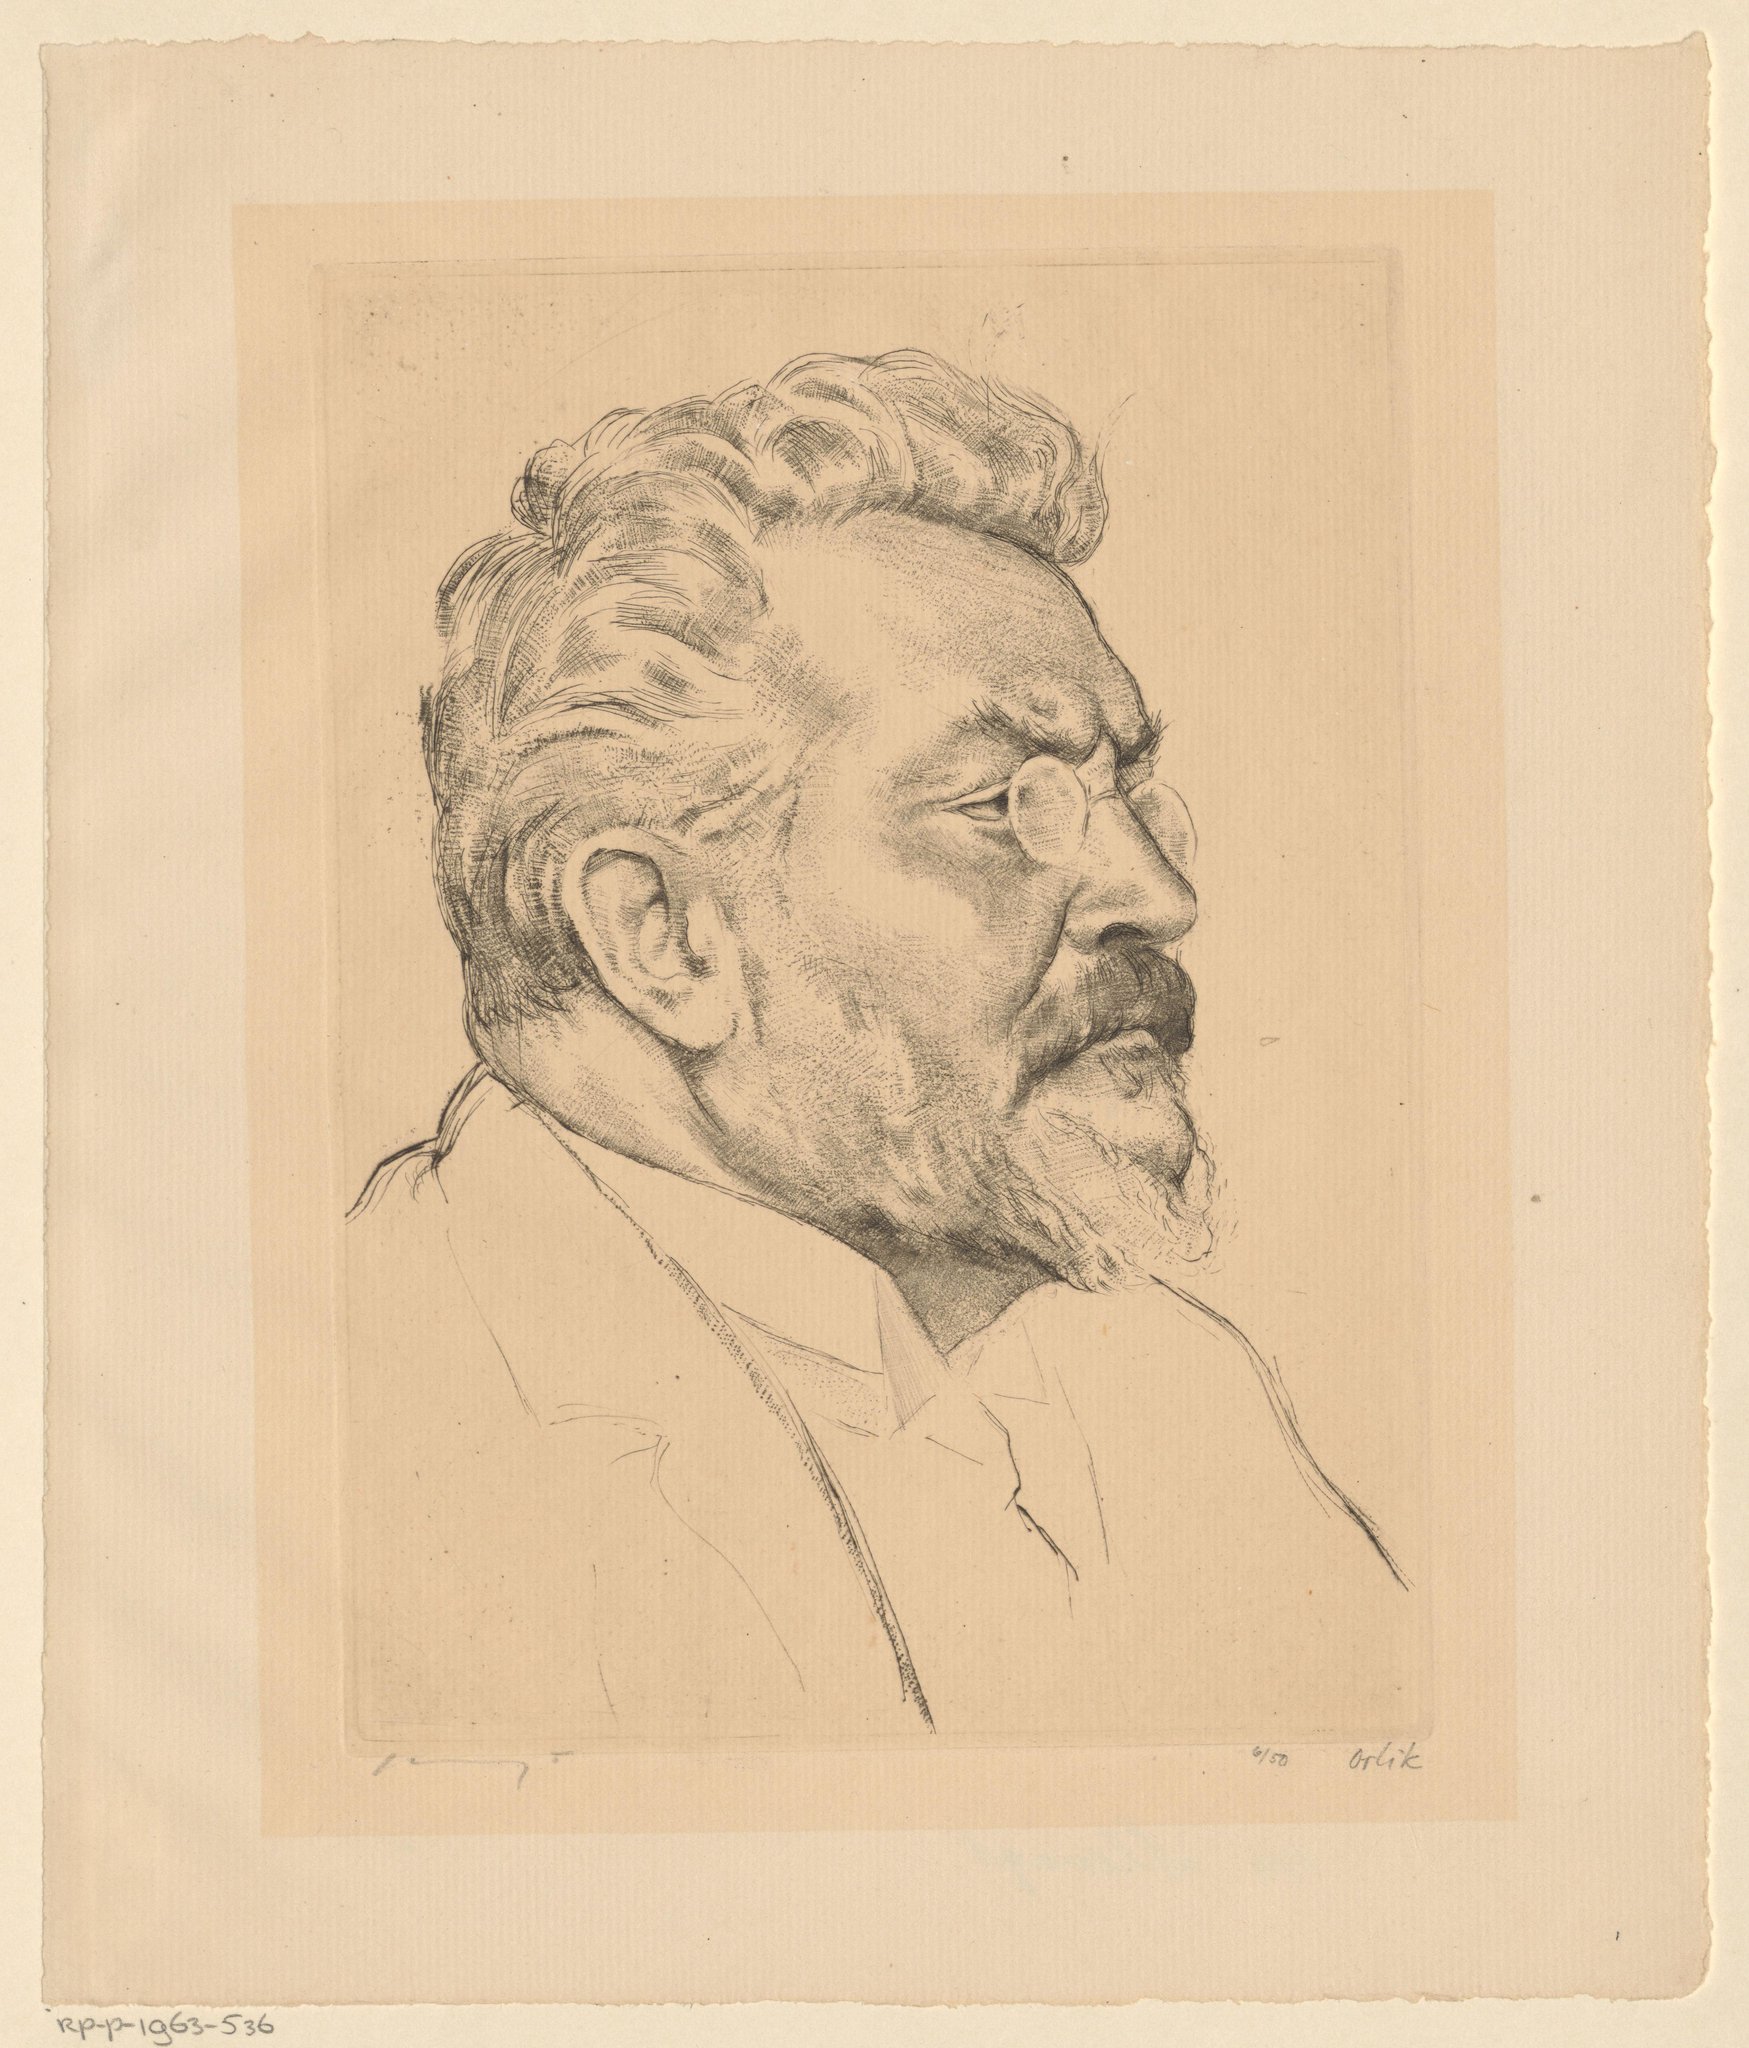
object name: print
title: Portret van Max Slevogt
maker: emil orlik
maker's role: painter, print maker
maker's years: 1870-1932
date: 1908-1932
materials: paper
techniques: etching, retroussage, roulette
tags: print maker, max slevogt, historical persons, portrait, self-portrait of artist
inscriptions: signature: ‘Orlik’, name: ‘Slevogt’, edition: ‘6/50’, collector's mark: Lugt 2228